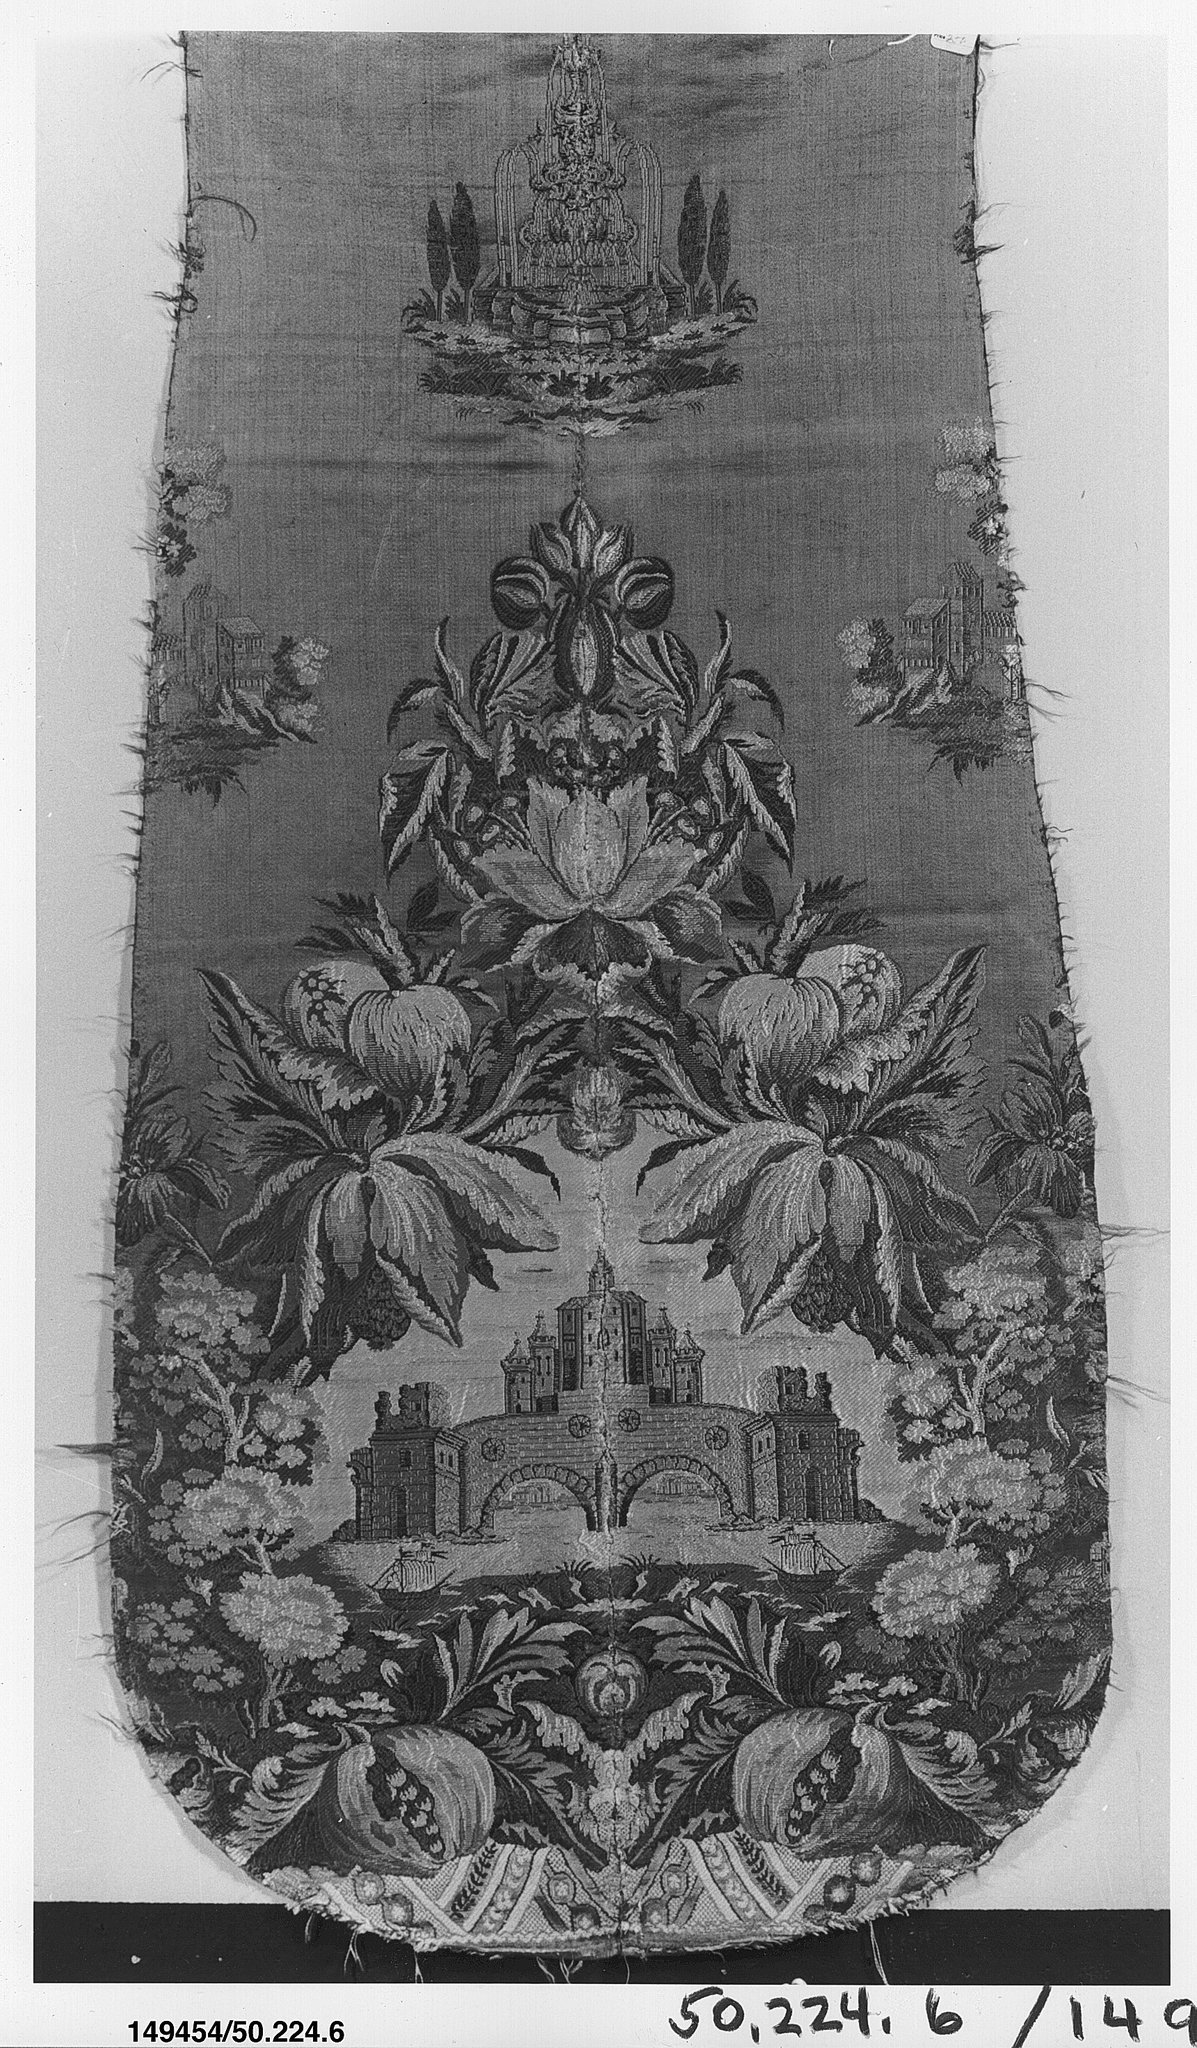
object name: piece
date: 1735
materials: silk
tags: buildings,flowers,leaves